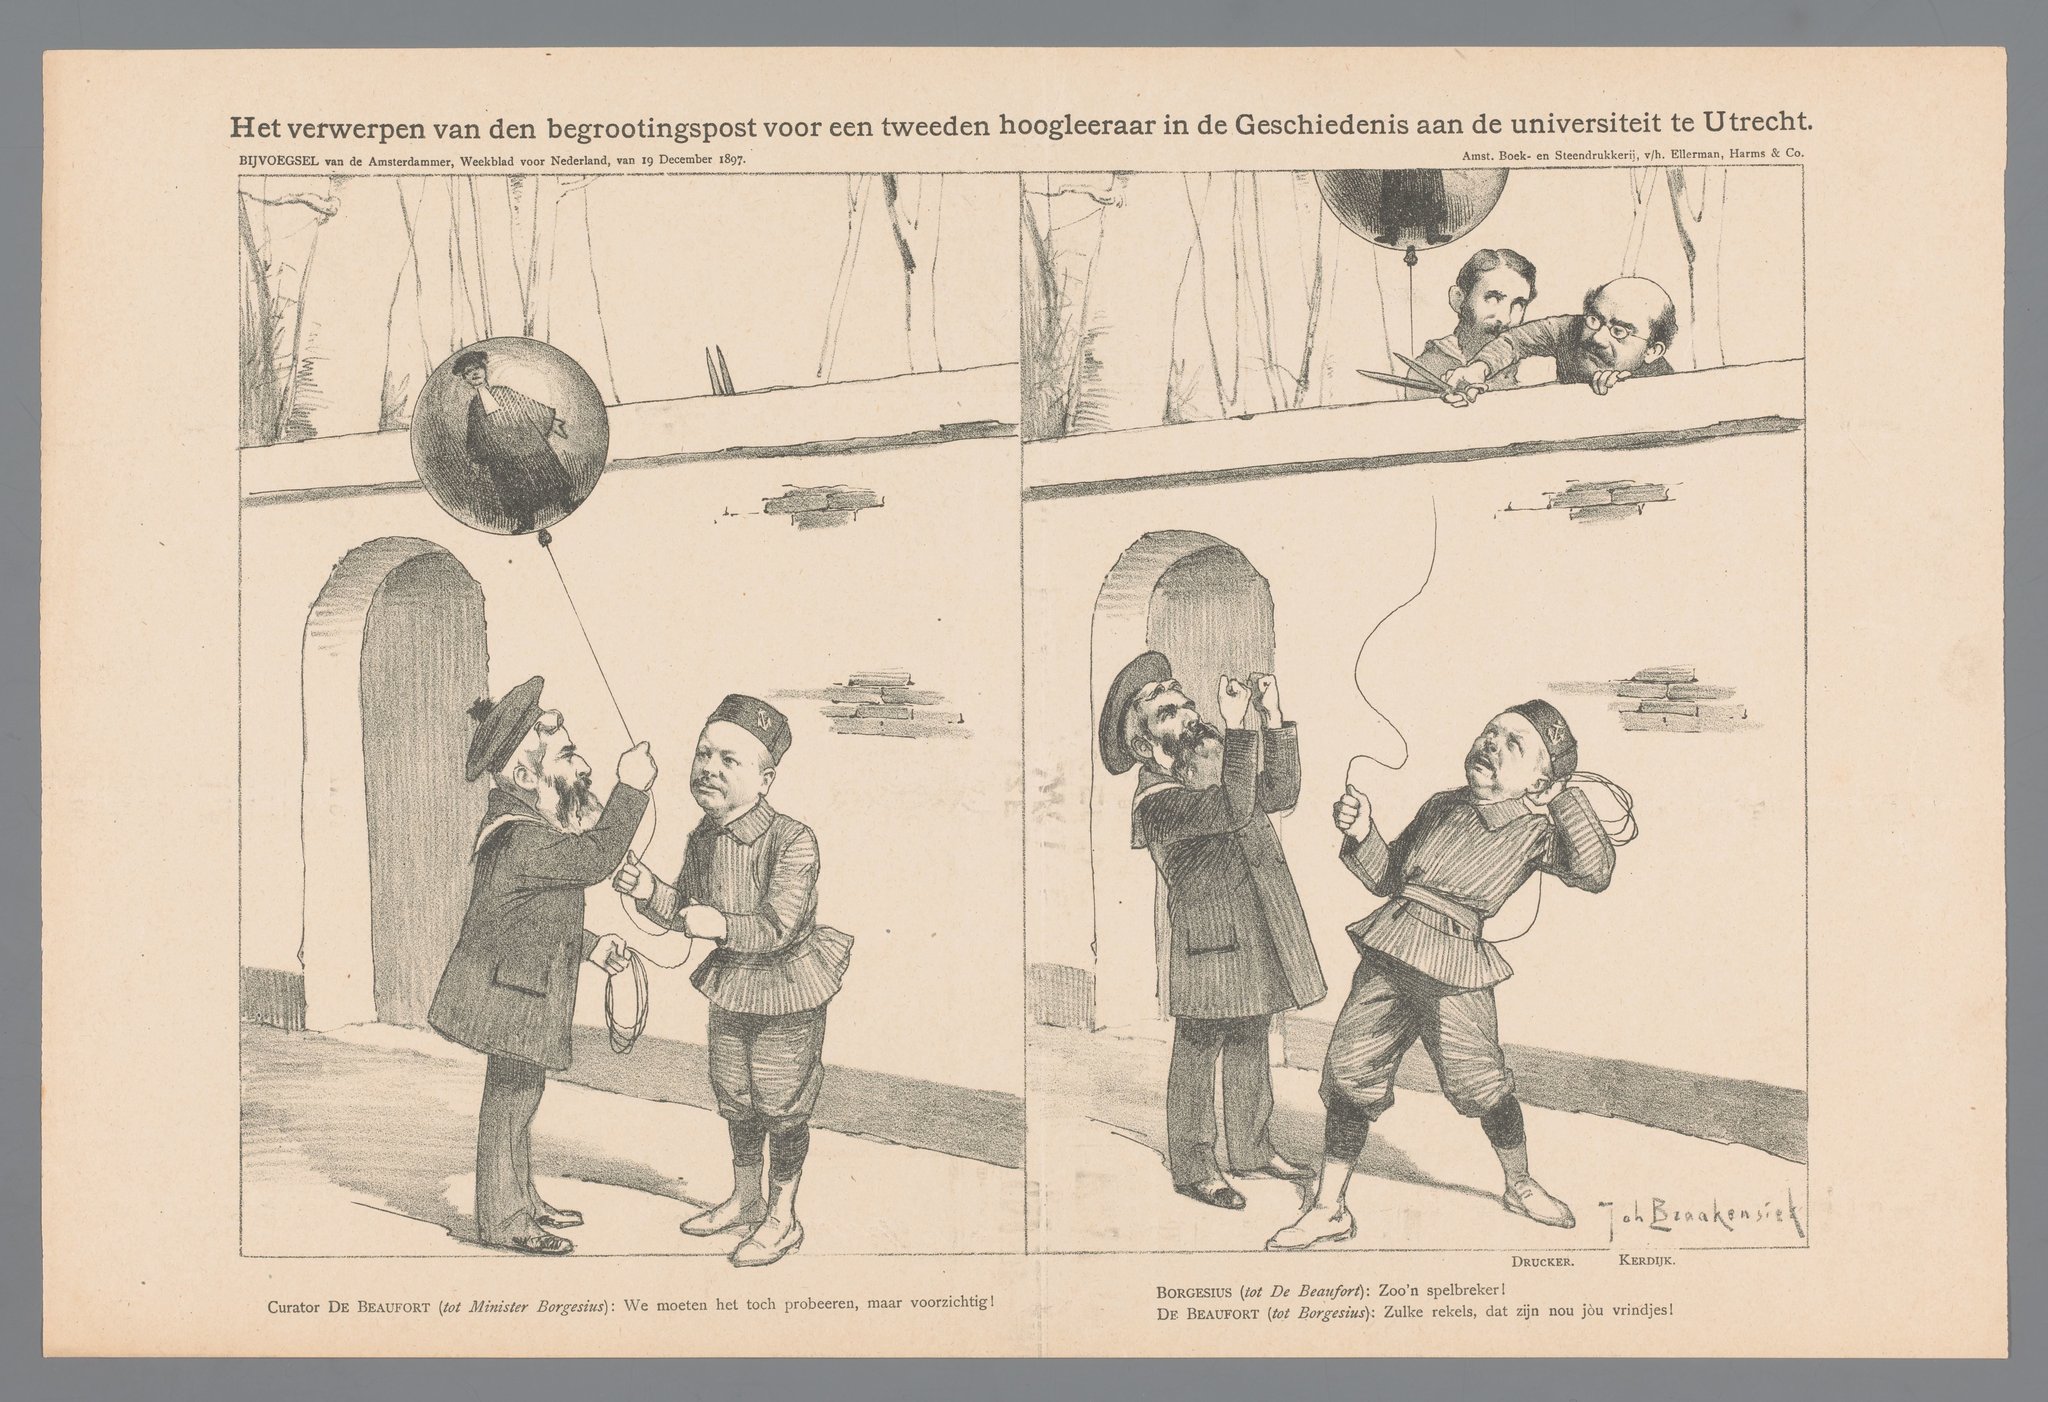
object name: cartoon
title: Het verwerpen van den begrootingspost voor een tweeden hoogleeraar in de Geschiedenis aan de universiteit te Utrecht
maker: johan braakensiek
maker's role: draughtsman, print maker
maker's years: 1858-1940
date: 1897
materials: paper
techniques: lithograph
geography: amsterdam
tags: amsterdam, the hague, politician, (flying a) gas balloon, historical persons, political caricatures and satires, utrecht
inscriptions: date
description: Prent uit het bijvoegsel van: De Amsterdammer. Weekblad voor Nederland, 19 december 1897.